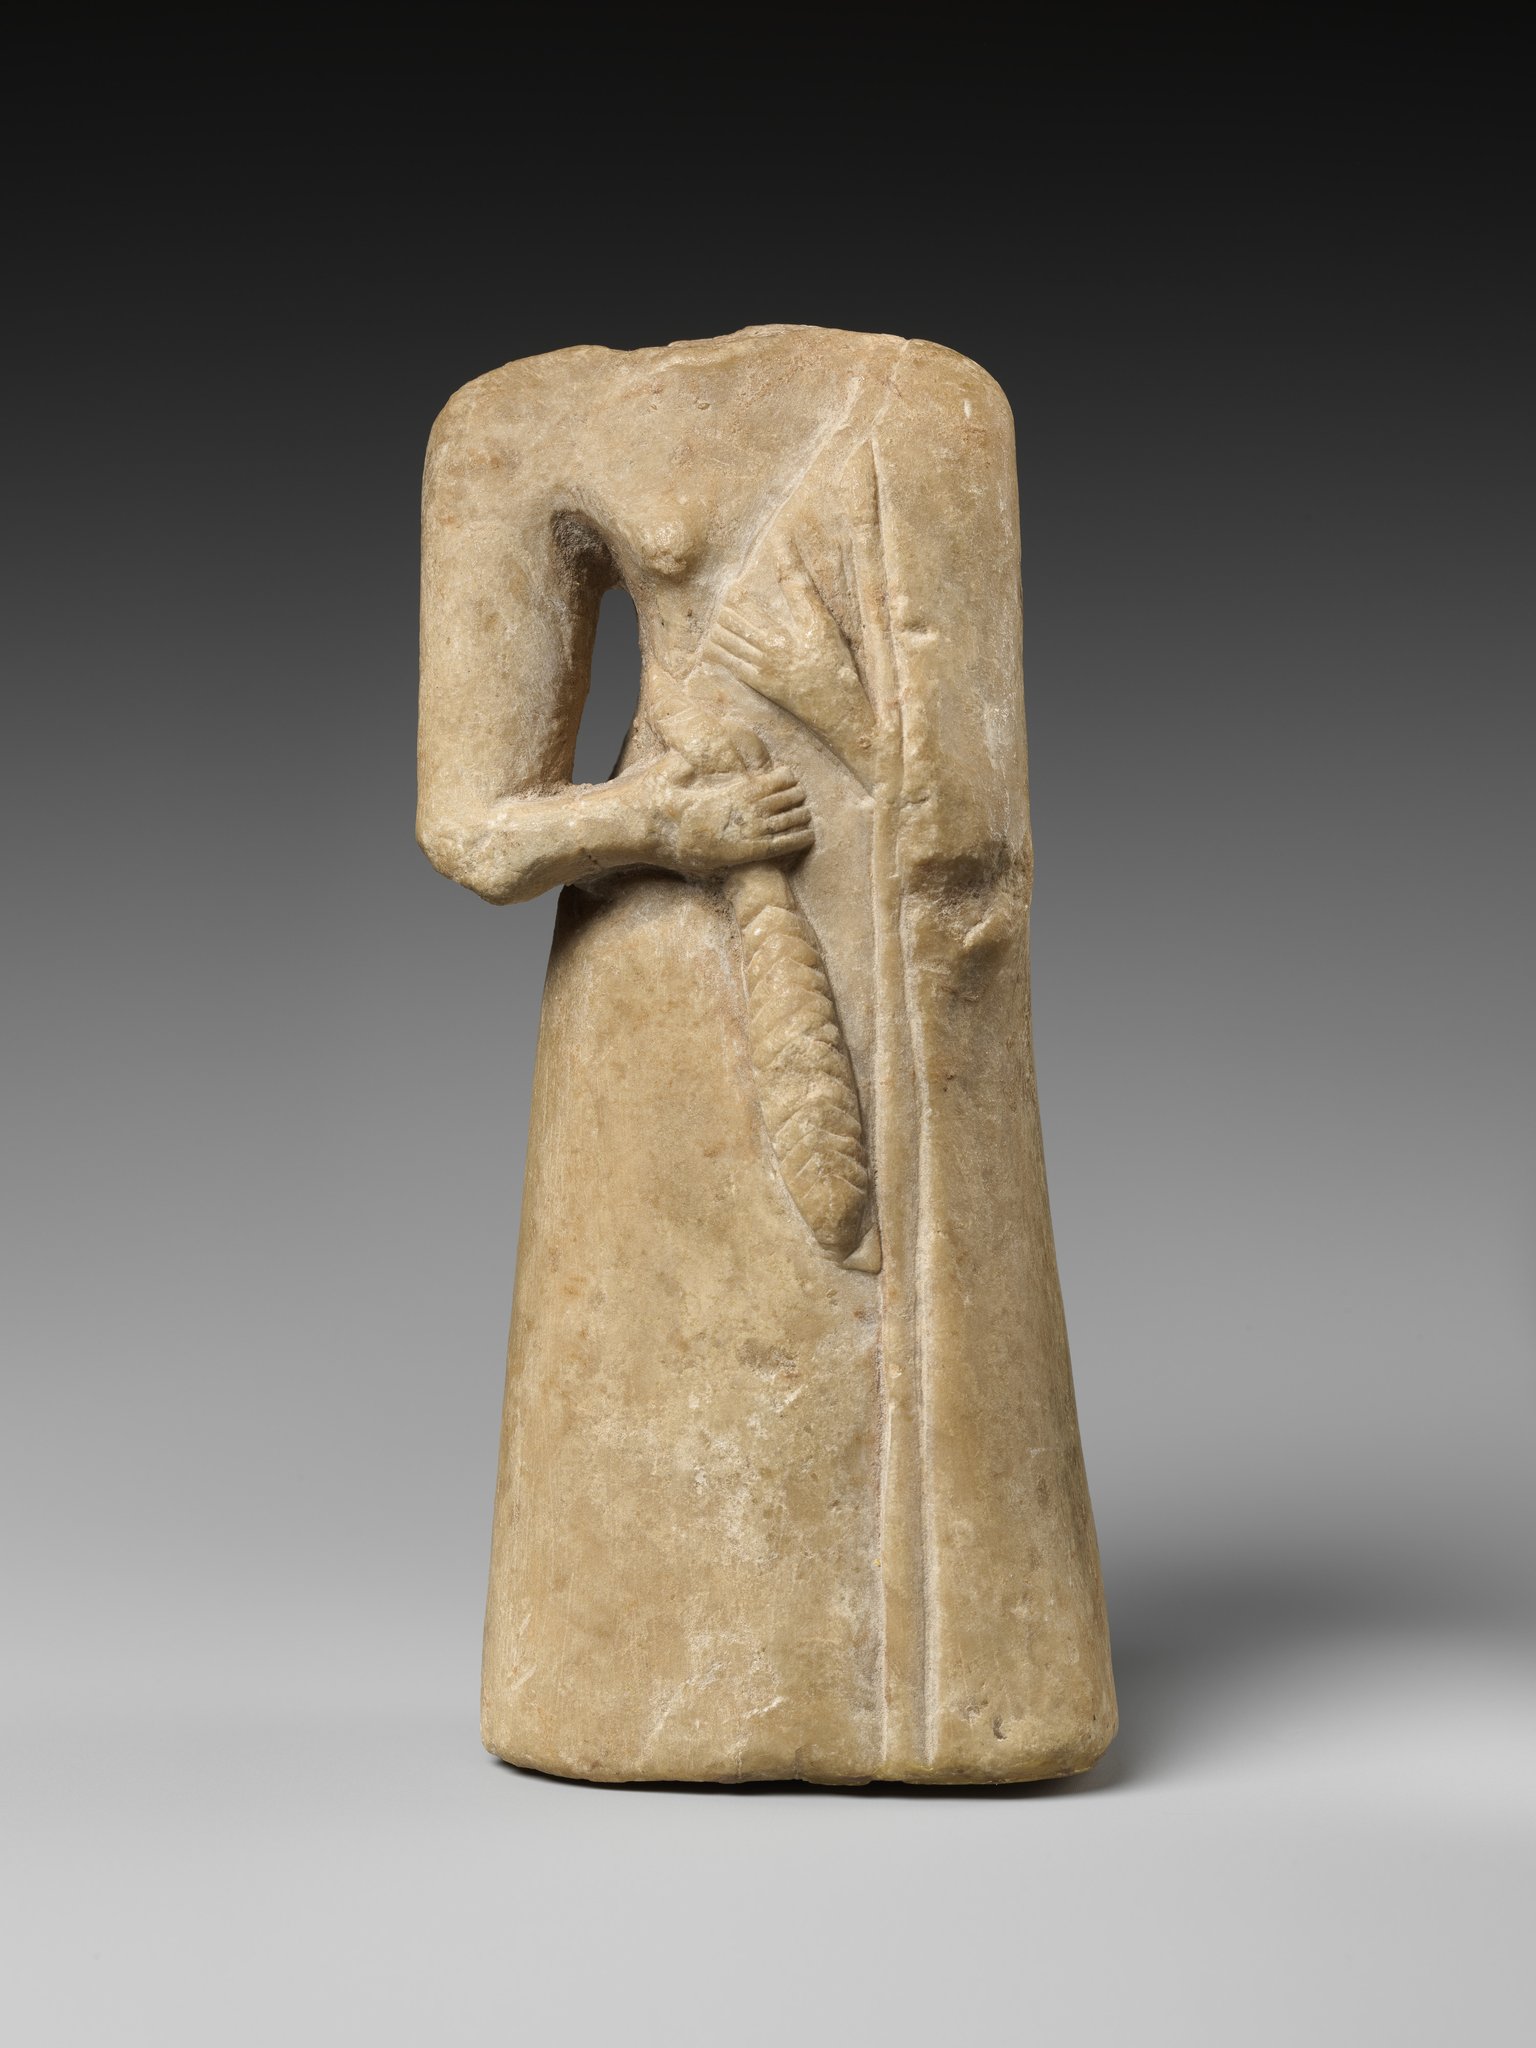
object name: sculpture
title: Standing female figure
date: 2700-2600 BCE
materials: alabaster, gypsum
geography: mesopotamia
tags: women